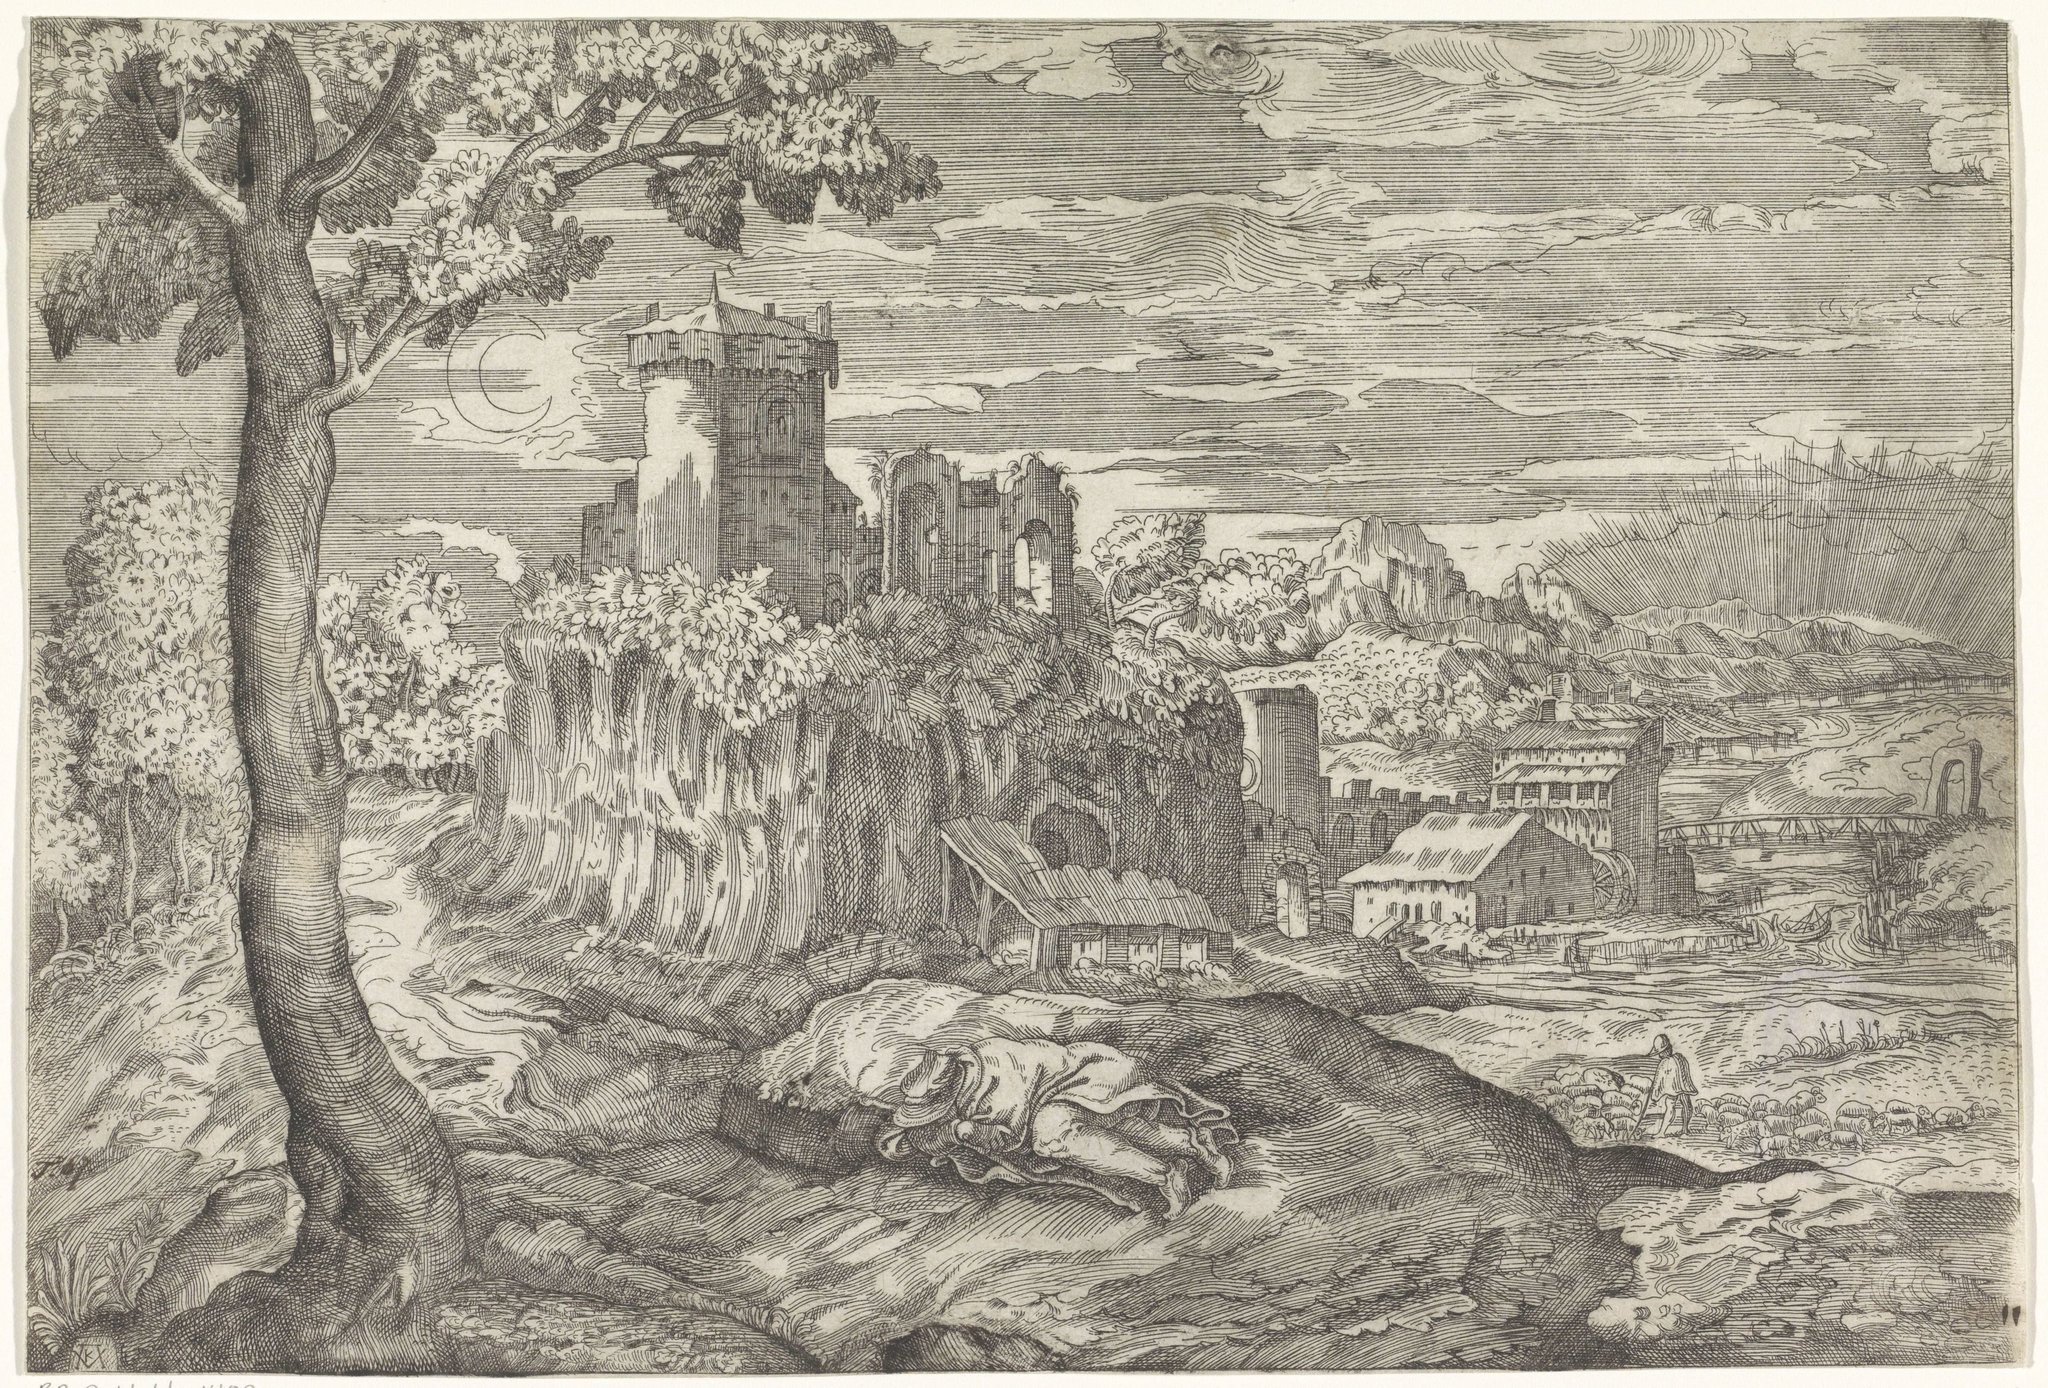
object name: print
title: Landschap met ruïne van kasteel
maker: mario cartaro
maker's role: print maker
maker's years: 1560-1620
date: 1560-1620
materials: paper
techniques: etching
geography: italy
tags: castle, herding, herdsman, herdswoman, shepherd, shepherdess, cowherd, etc., sleeping on the ground - bb - out of doors, landscape with ruins - ii - ideal landscapes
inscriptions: collector's mark: Lugt 11, number: ‘11’, collector's mark: Lugt 2228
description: Een landschap met ruïne van kasteel. Op de voorgrond een slapende herder. Rechts een herder met een kudde schapen.